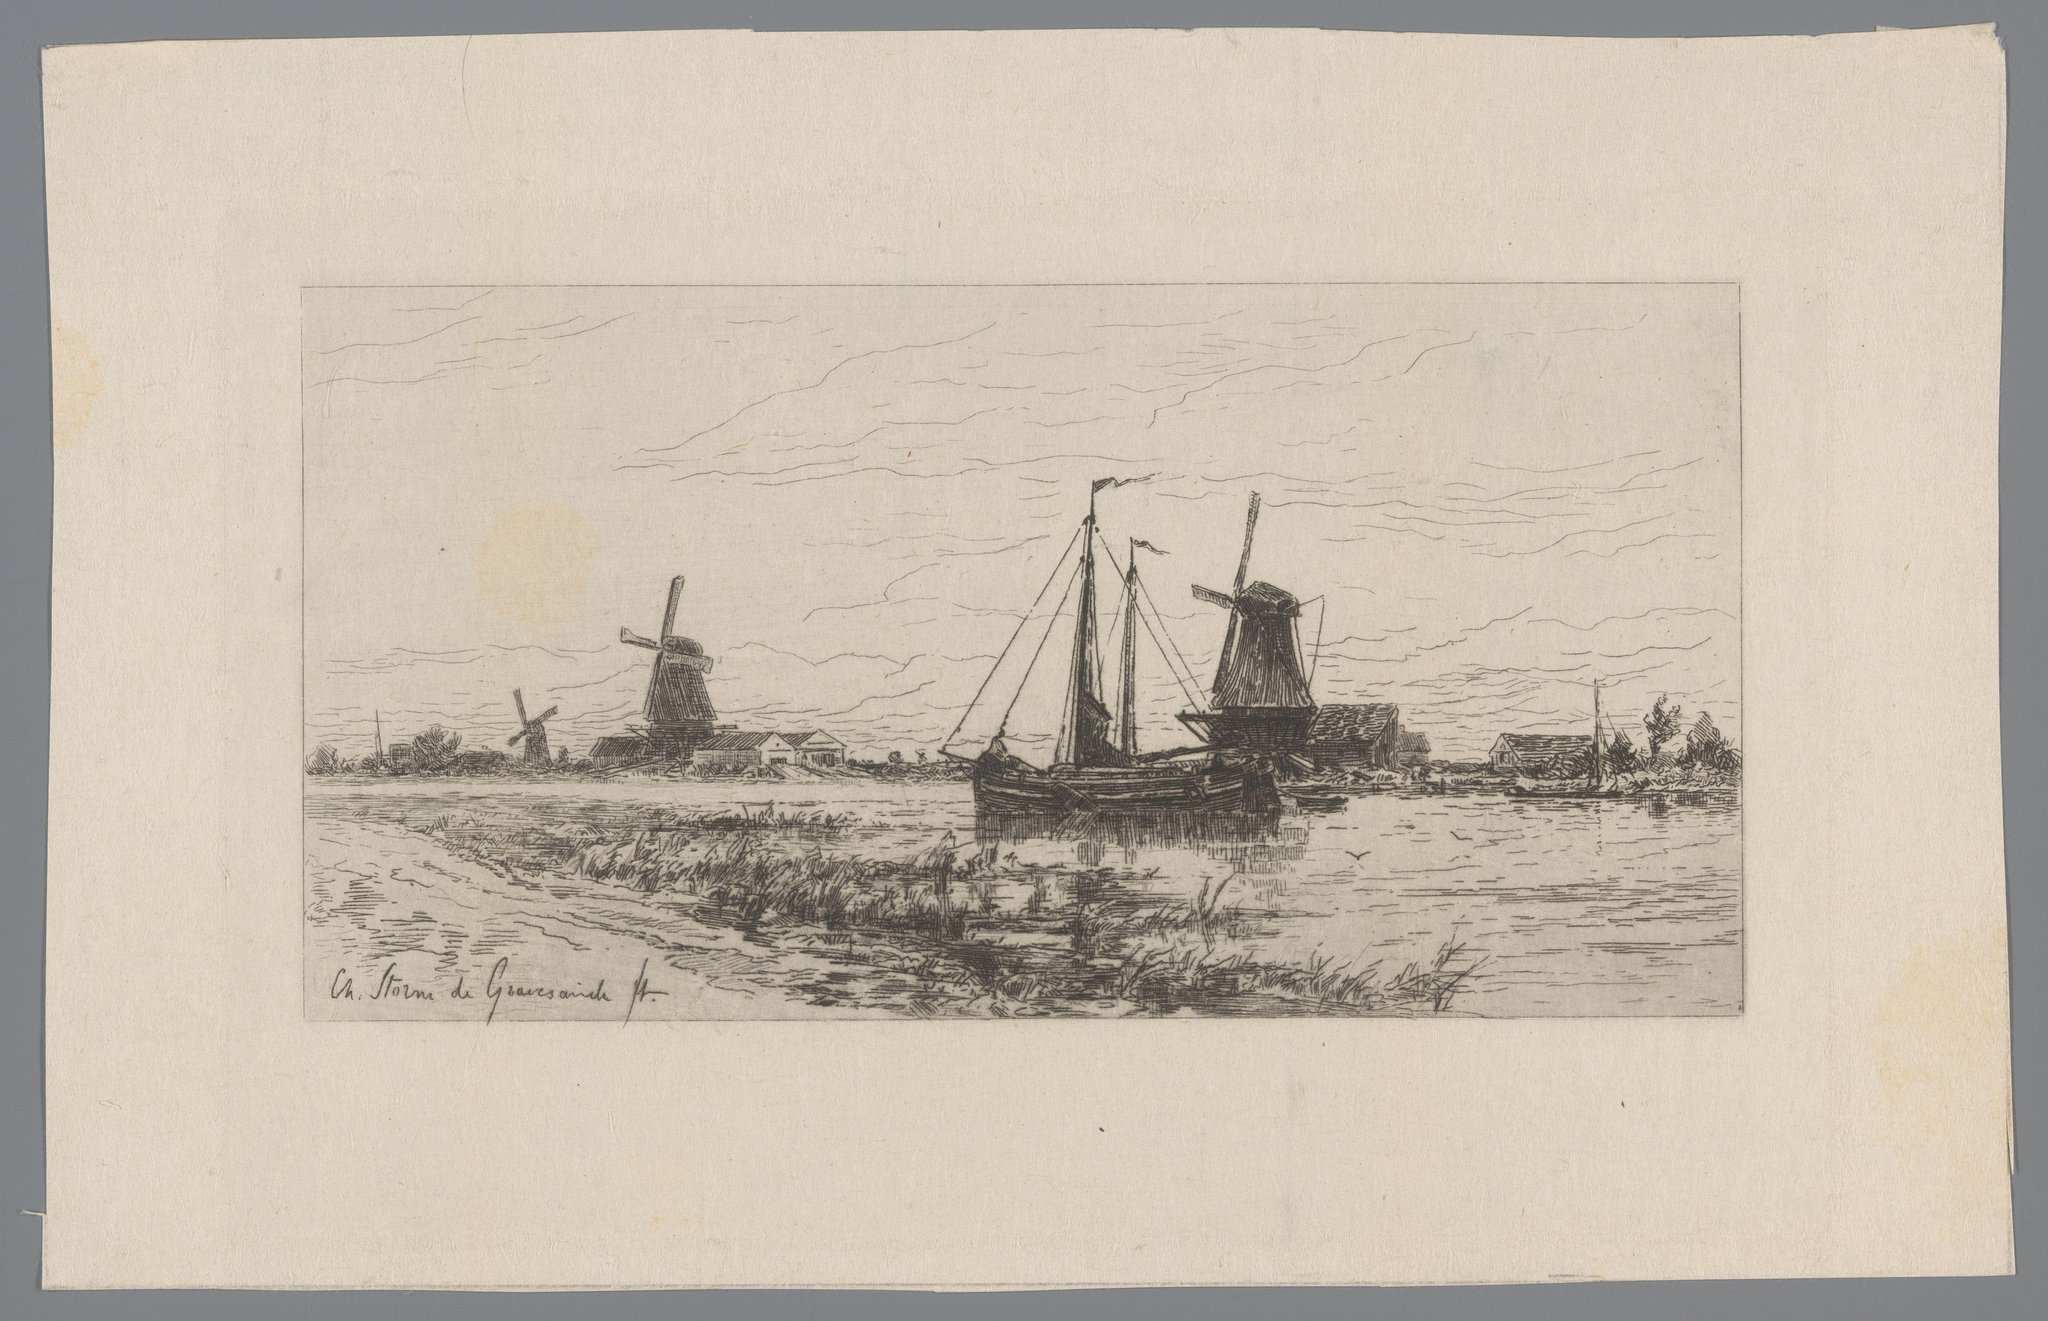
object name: print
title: Molens aan de Vecht bij Weesp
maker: carel nicolaas storm van s-gravesande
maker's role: draughtsman, print maker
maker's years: 1841-1924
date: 1851-1924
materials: paper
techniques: etching, intaglio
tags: sailing-ship, sailing-boat, windmill in landscape, vecht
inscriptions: collector's mark: Lugt 2233